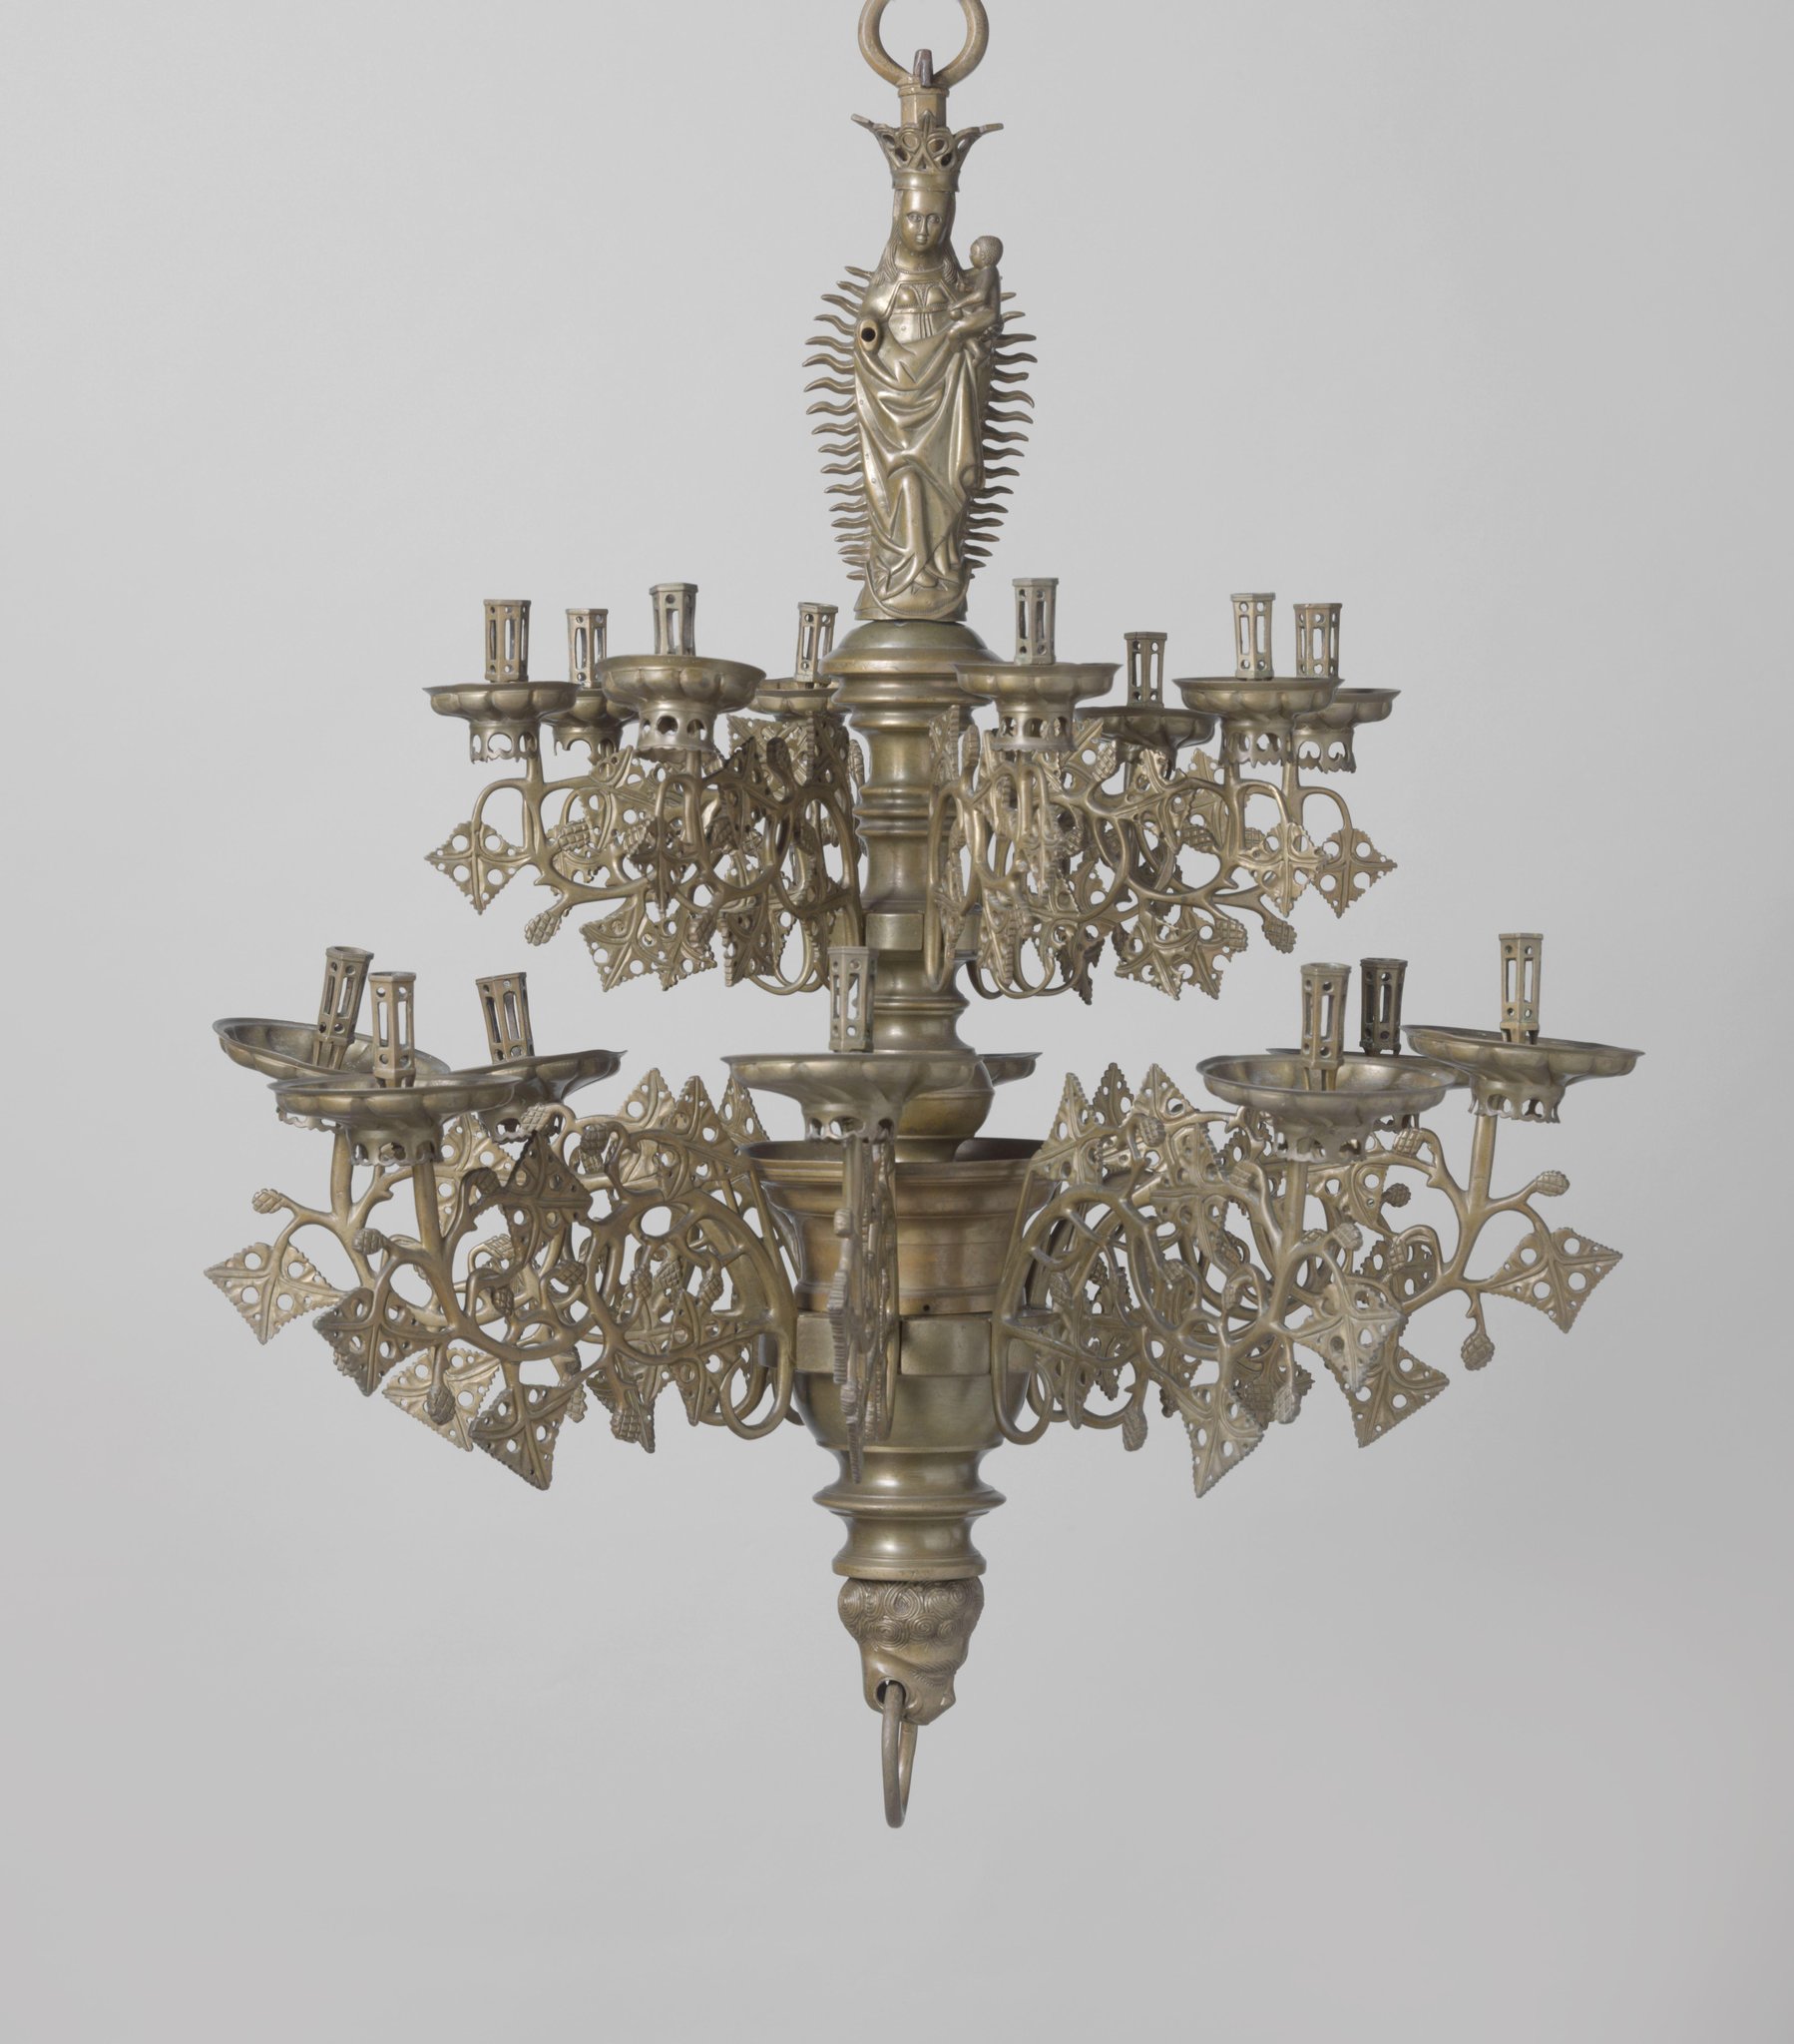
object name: chandelier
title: Arm met kaarsenhouder van kaarsenkroon van twee hoogten met ieder acht armen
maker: Anonymous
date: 1525-1550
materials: brass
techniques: casting, screwed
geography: southern netherlands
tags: vine-tendril, leaf, mary standing (or half-length), the christ-child sitting on her arm (christ-child to mary's left)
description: Kaarsenarm behorende bij een kaarsenkroon van twee hoogten met Mariafiguur bovenaan. De arm is twee maal gebogen en is versierd met negen druiventrossen en vijf wingerdbladeren. De ronde vetvanger is aan de onderkant versierd met visblaasmotieven en heeft naar het midden toe een naar beneden uitstekende rand van kruisbloemen, die de plaatsing op de arm maskeert. De kaarsenhouder is zesvlakkig, opengewerkt, geplaatst op drie verticale stijlen, overgaande in een uitsteeksel met schroefdraad. Dit is de tweede arm van de onderste ring, genummerd met 5 ronde punten. De kaarsenhouder is ongenummerd.